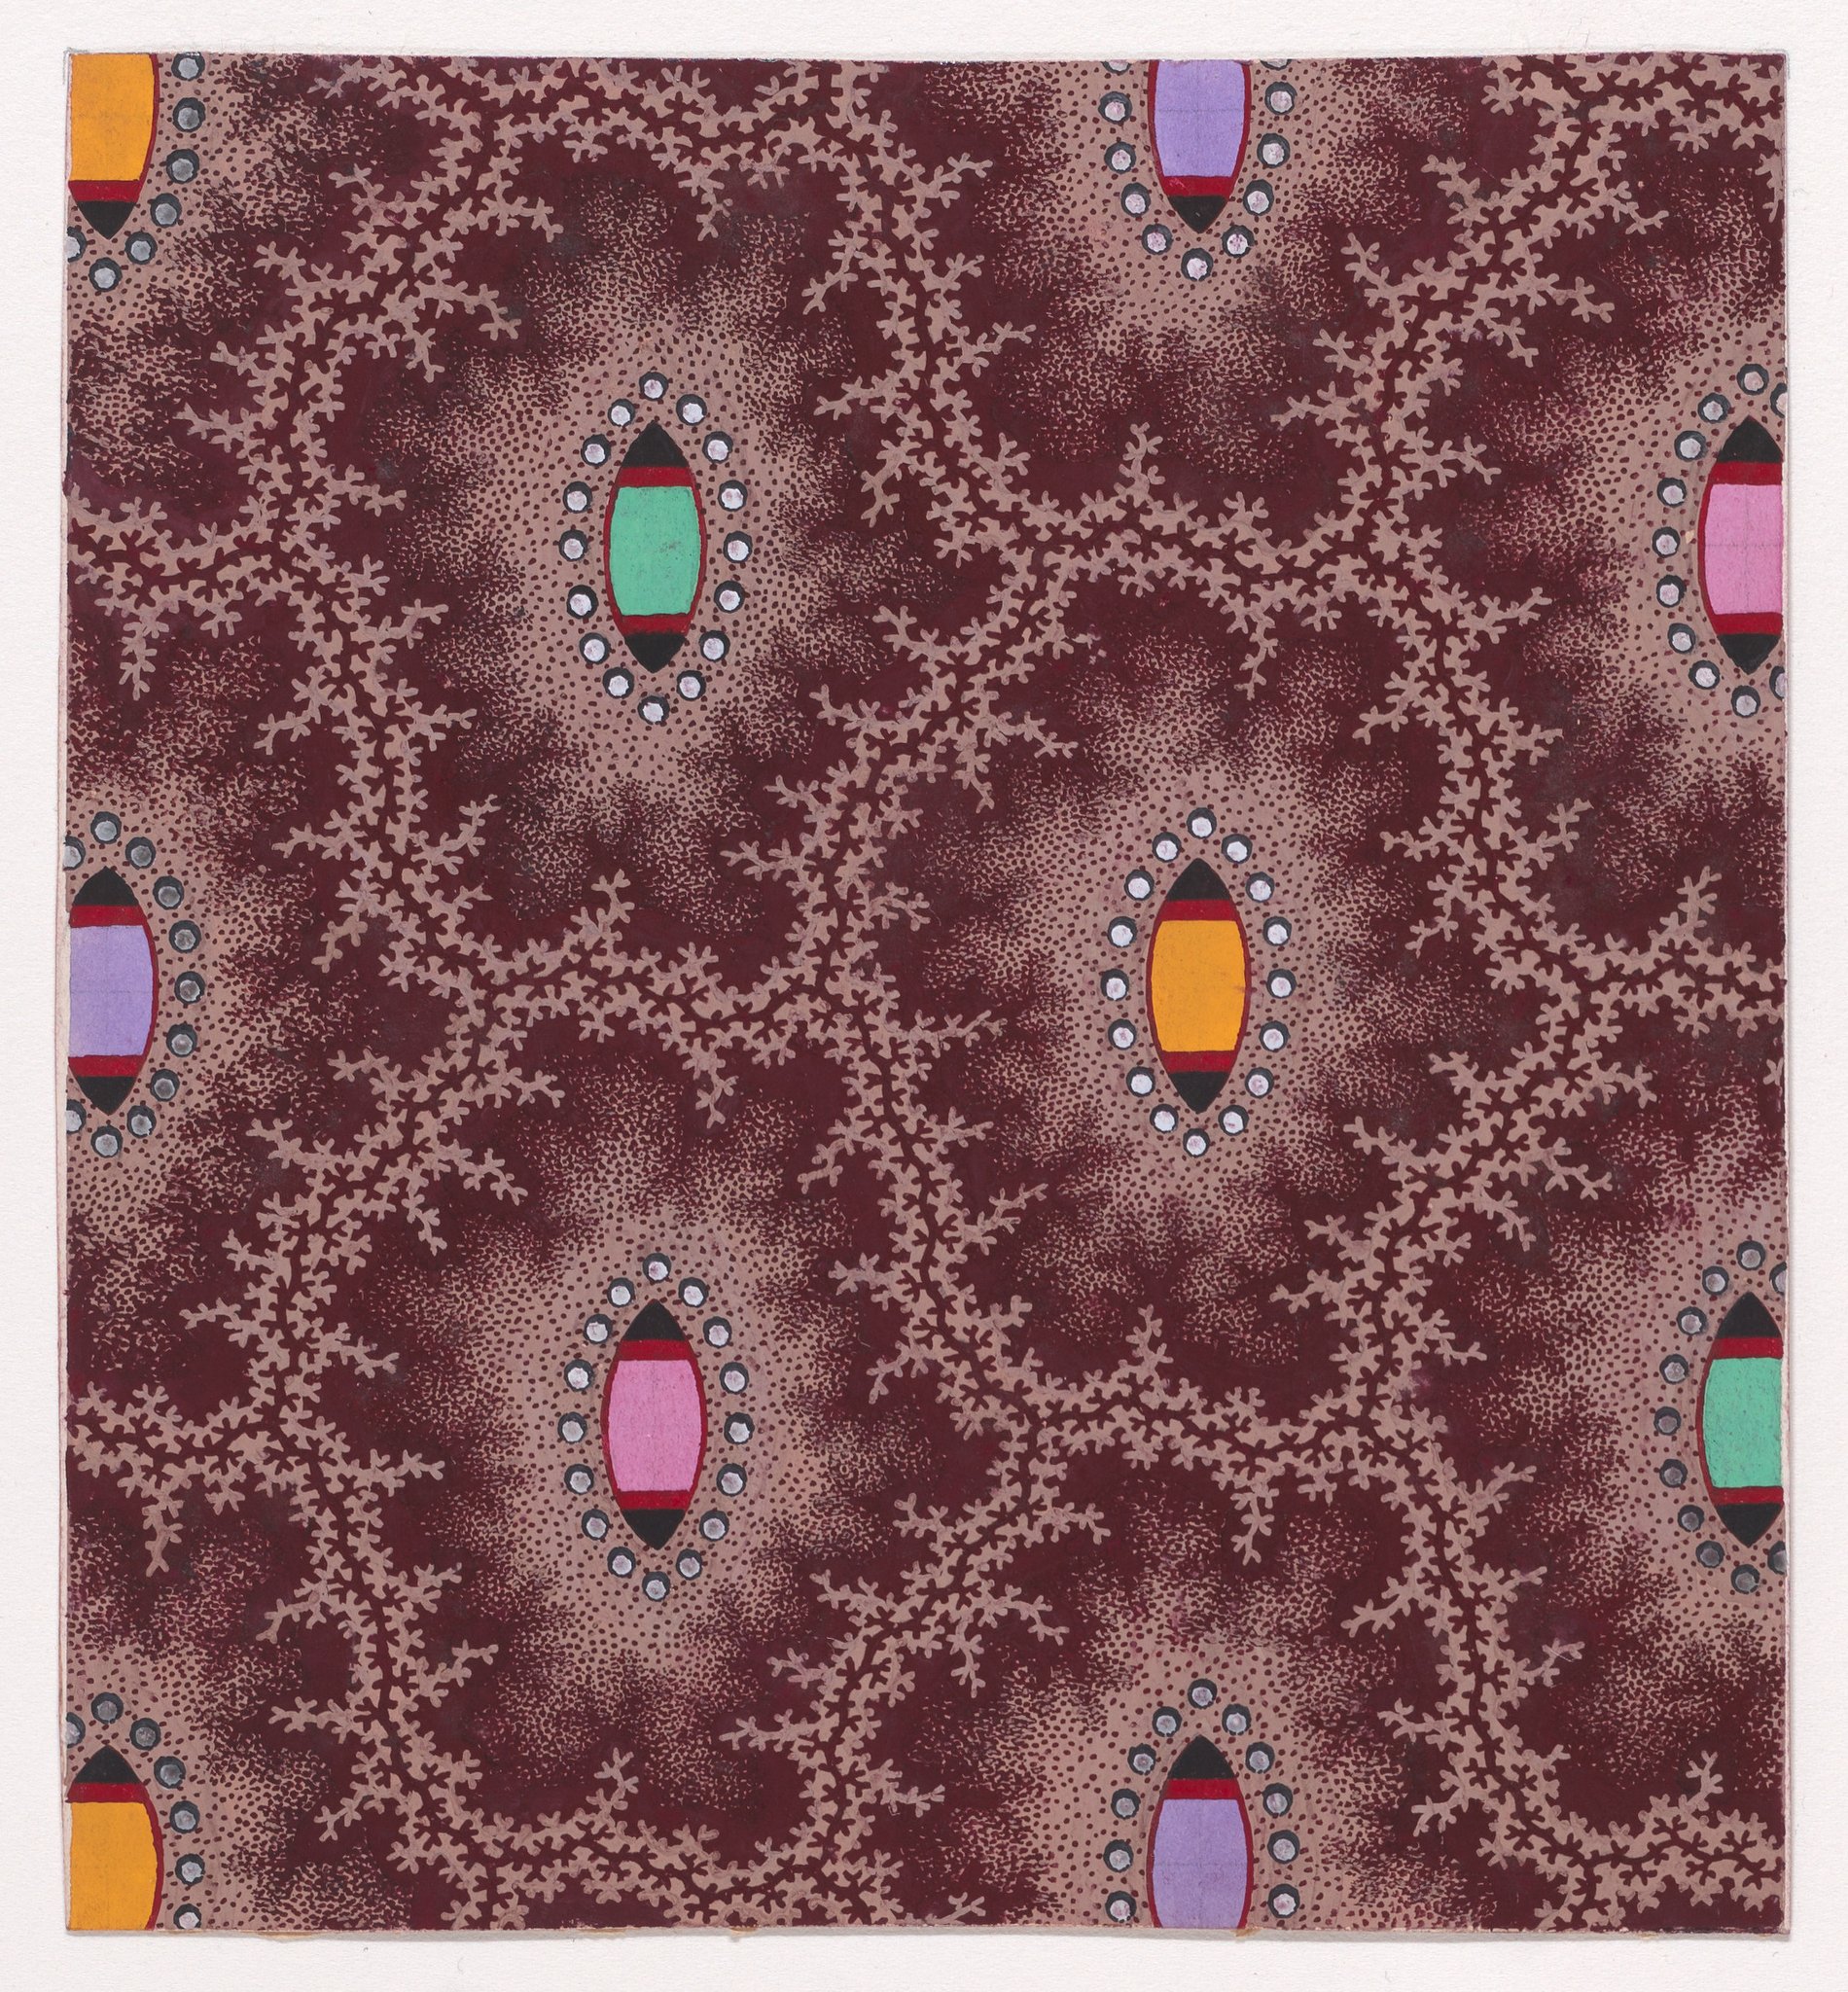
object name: drawing ornament architecture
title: Textile Design with Alternating Vertical Rows of Shuttle Shapes and Pearls Framed by Interlacing Garlands of Branches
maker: anonymous, alsatian, 19th century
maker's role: artist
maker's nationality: alsatian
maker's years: 1800-1900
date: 1840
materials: gouache